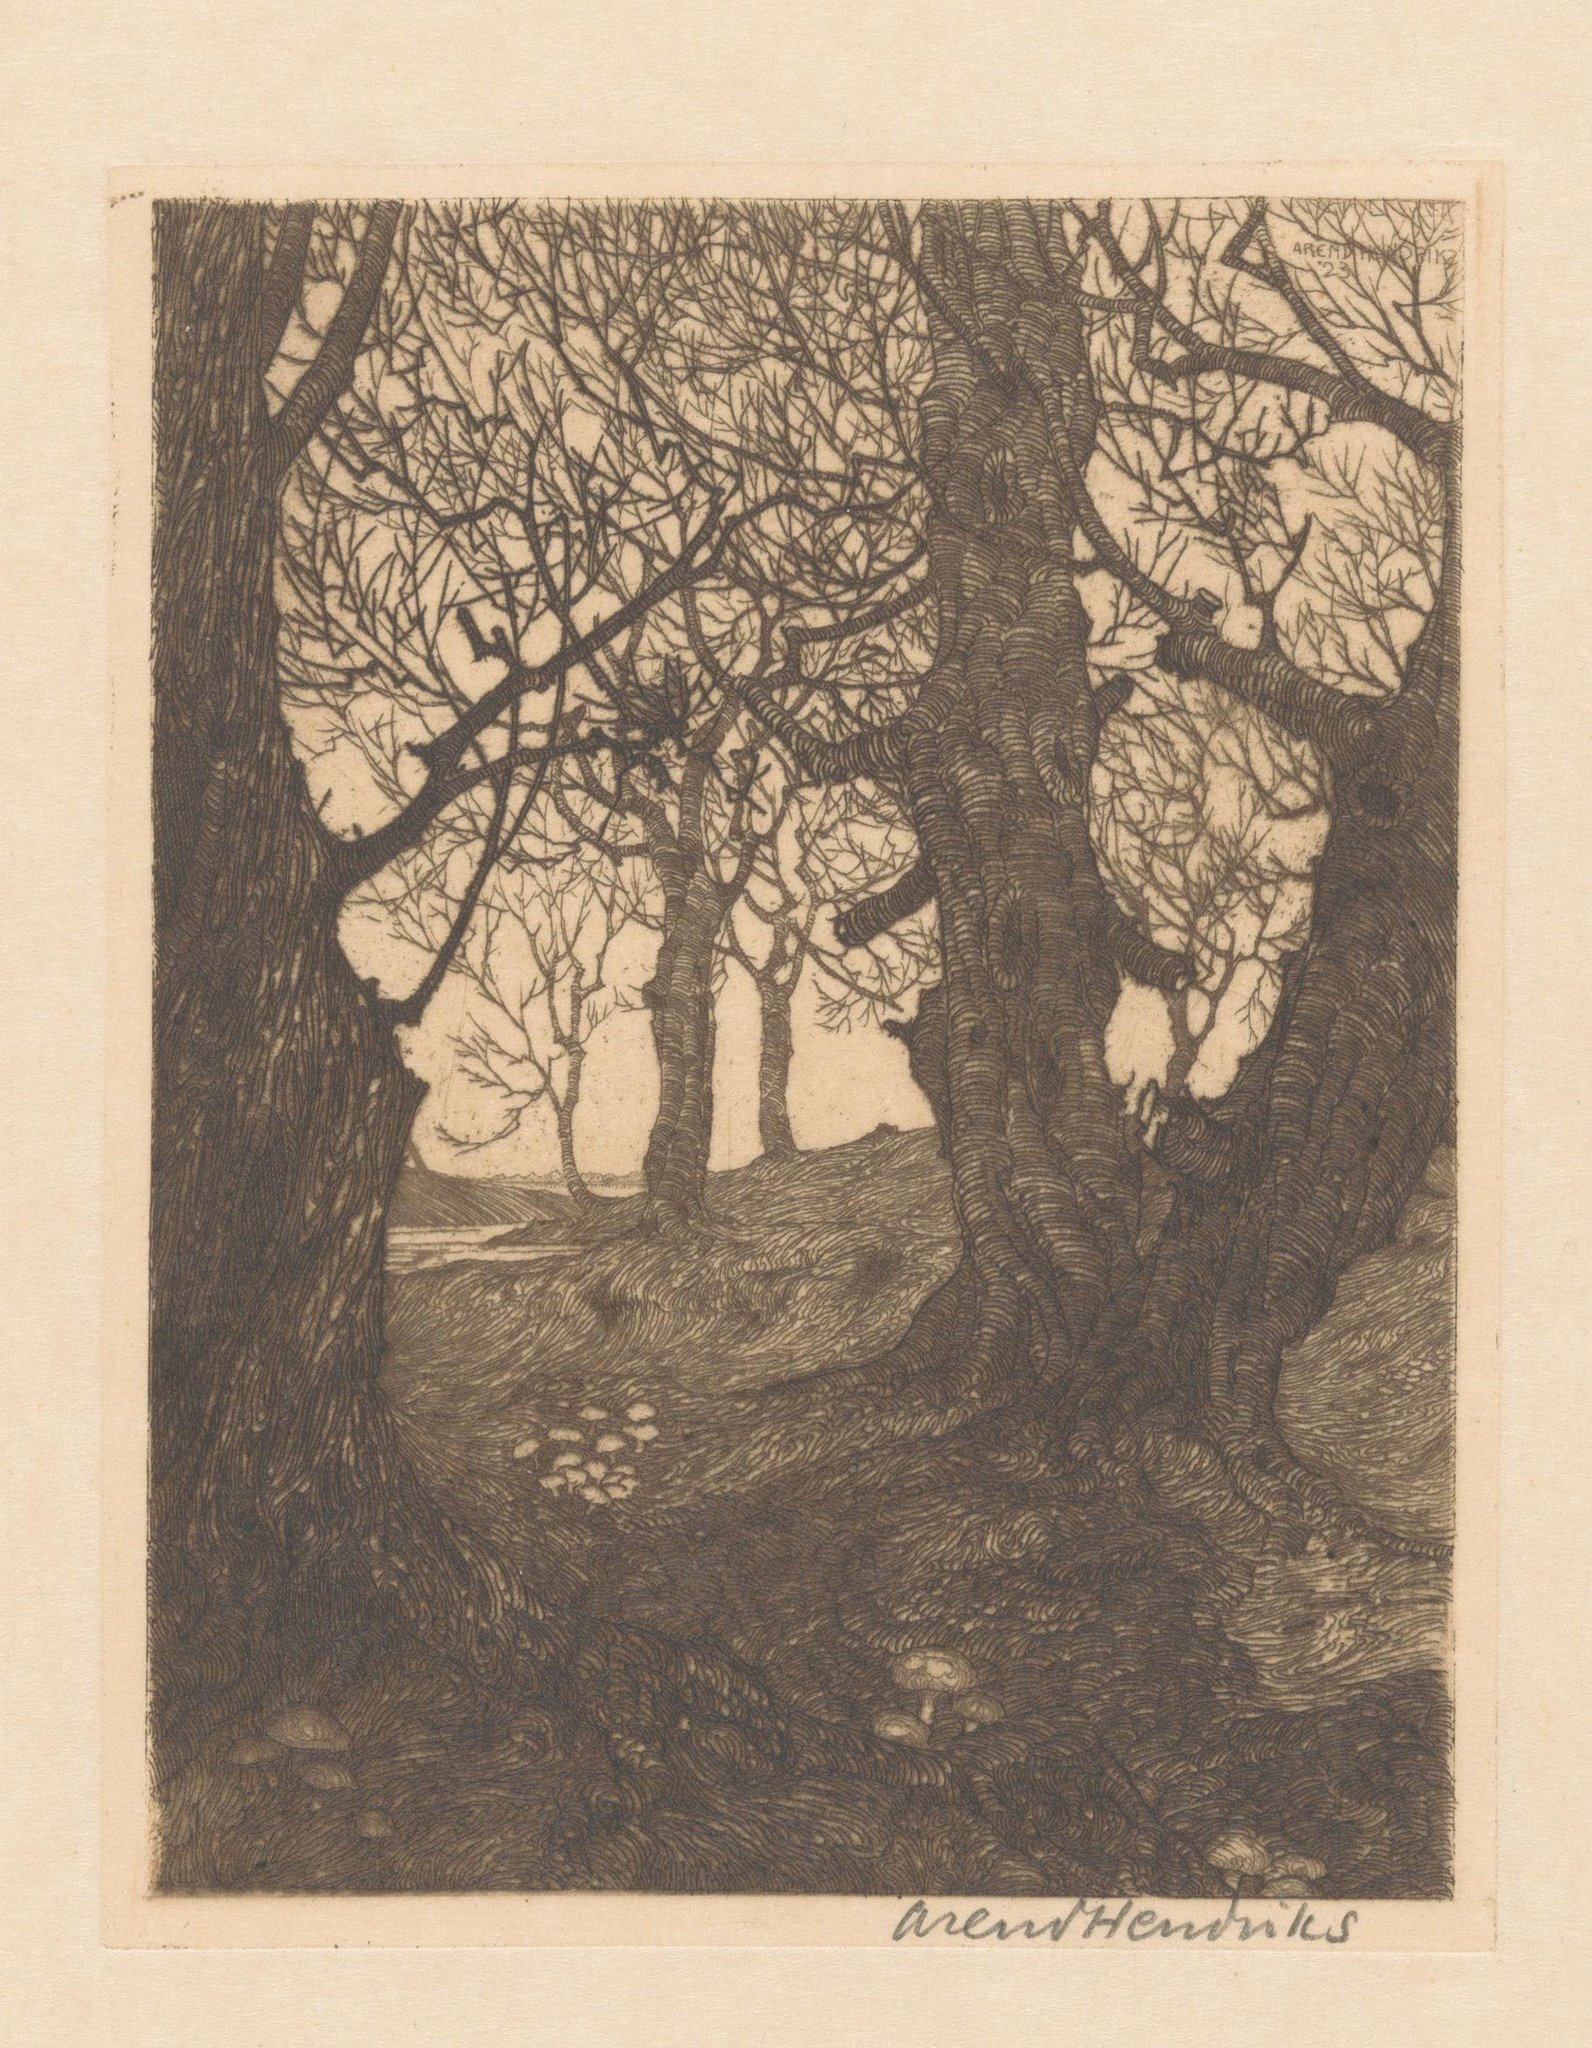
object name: print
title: Pad door een bos met kale bomen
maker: arend hendriks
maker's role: print maker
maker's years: 1901-1951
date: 1911-1931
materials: paper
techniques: etching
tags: forest path or lane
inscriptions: collector's mark: Lugt 2228